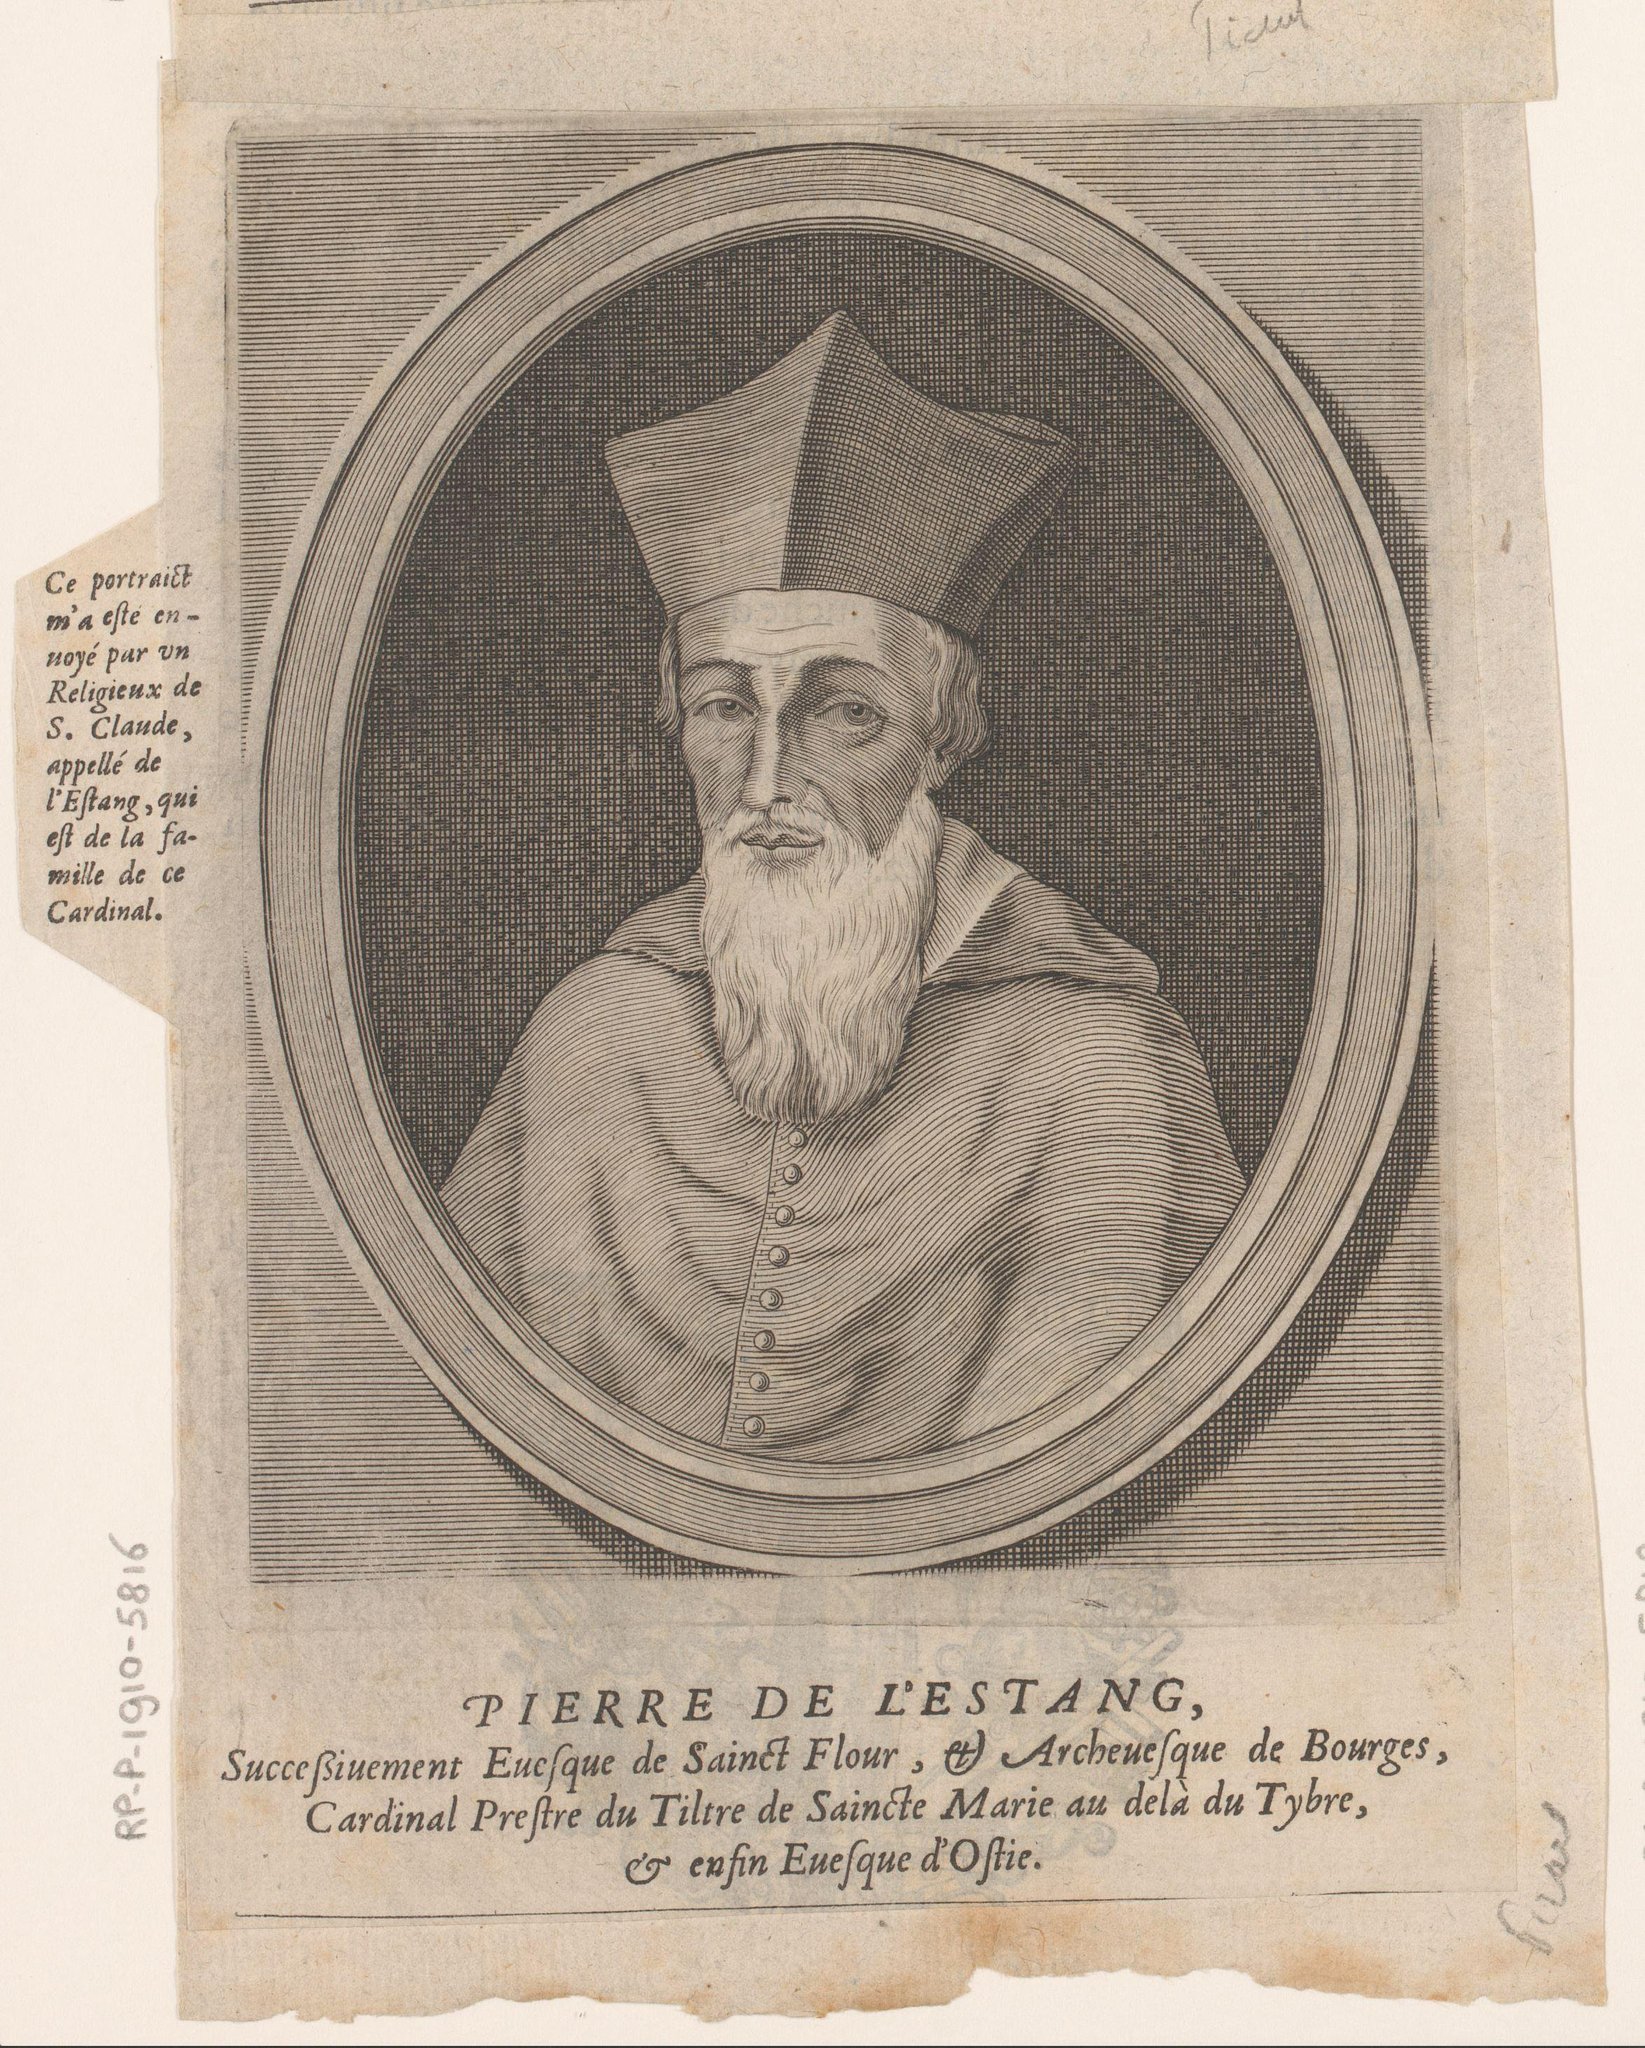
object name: print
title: Pierre de l'Estang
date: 1660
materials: paper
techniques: engraving, etching, letterpress printing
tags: rome, cardinal, historical persons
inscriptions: collector's mark: Lugt 2228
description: Prent uit: Du Chesne, François. Histoire de tous les cardinaux françois de naissance, ou qui ont esté promeus au cardinalat. Parijs: François Du Chesne, 1660.